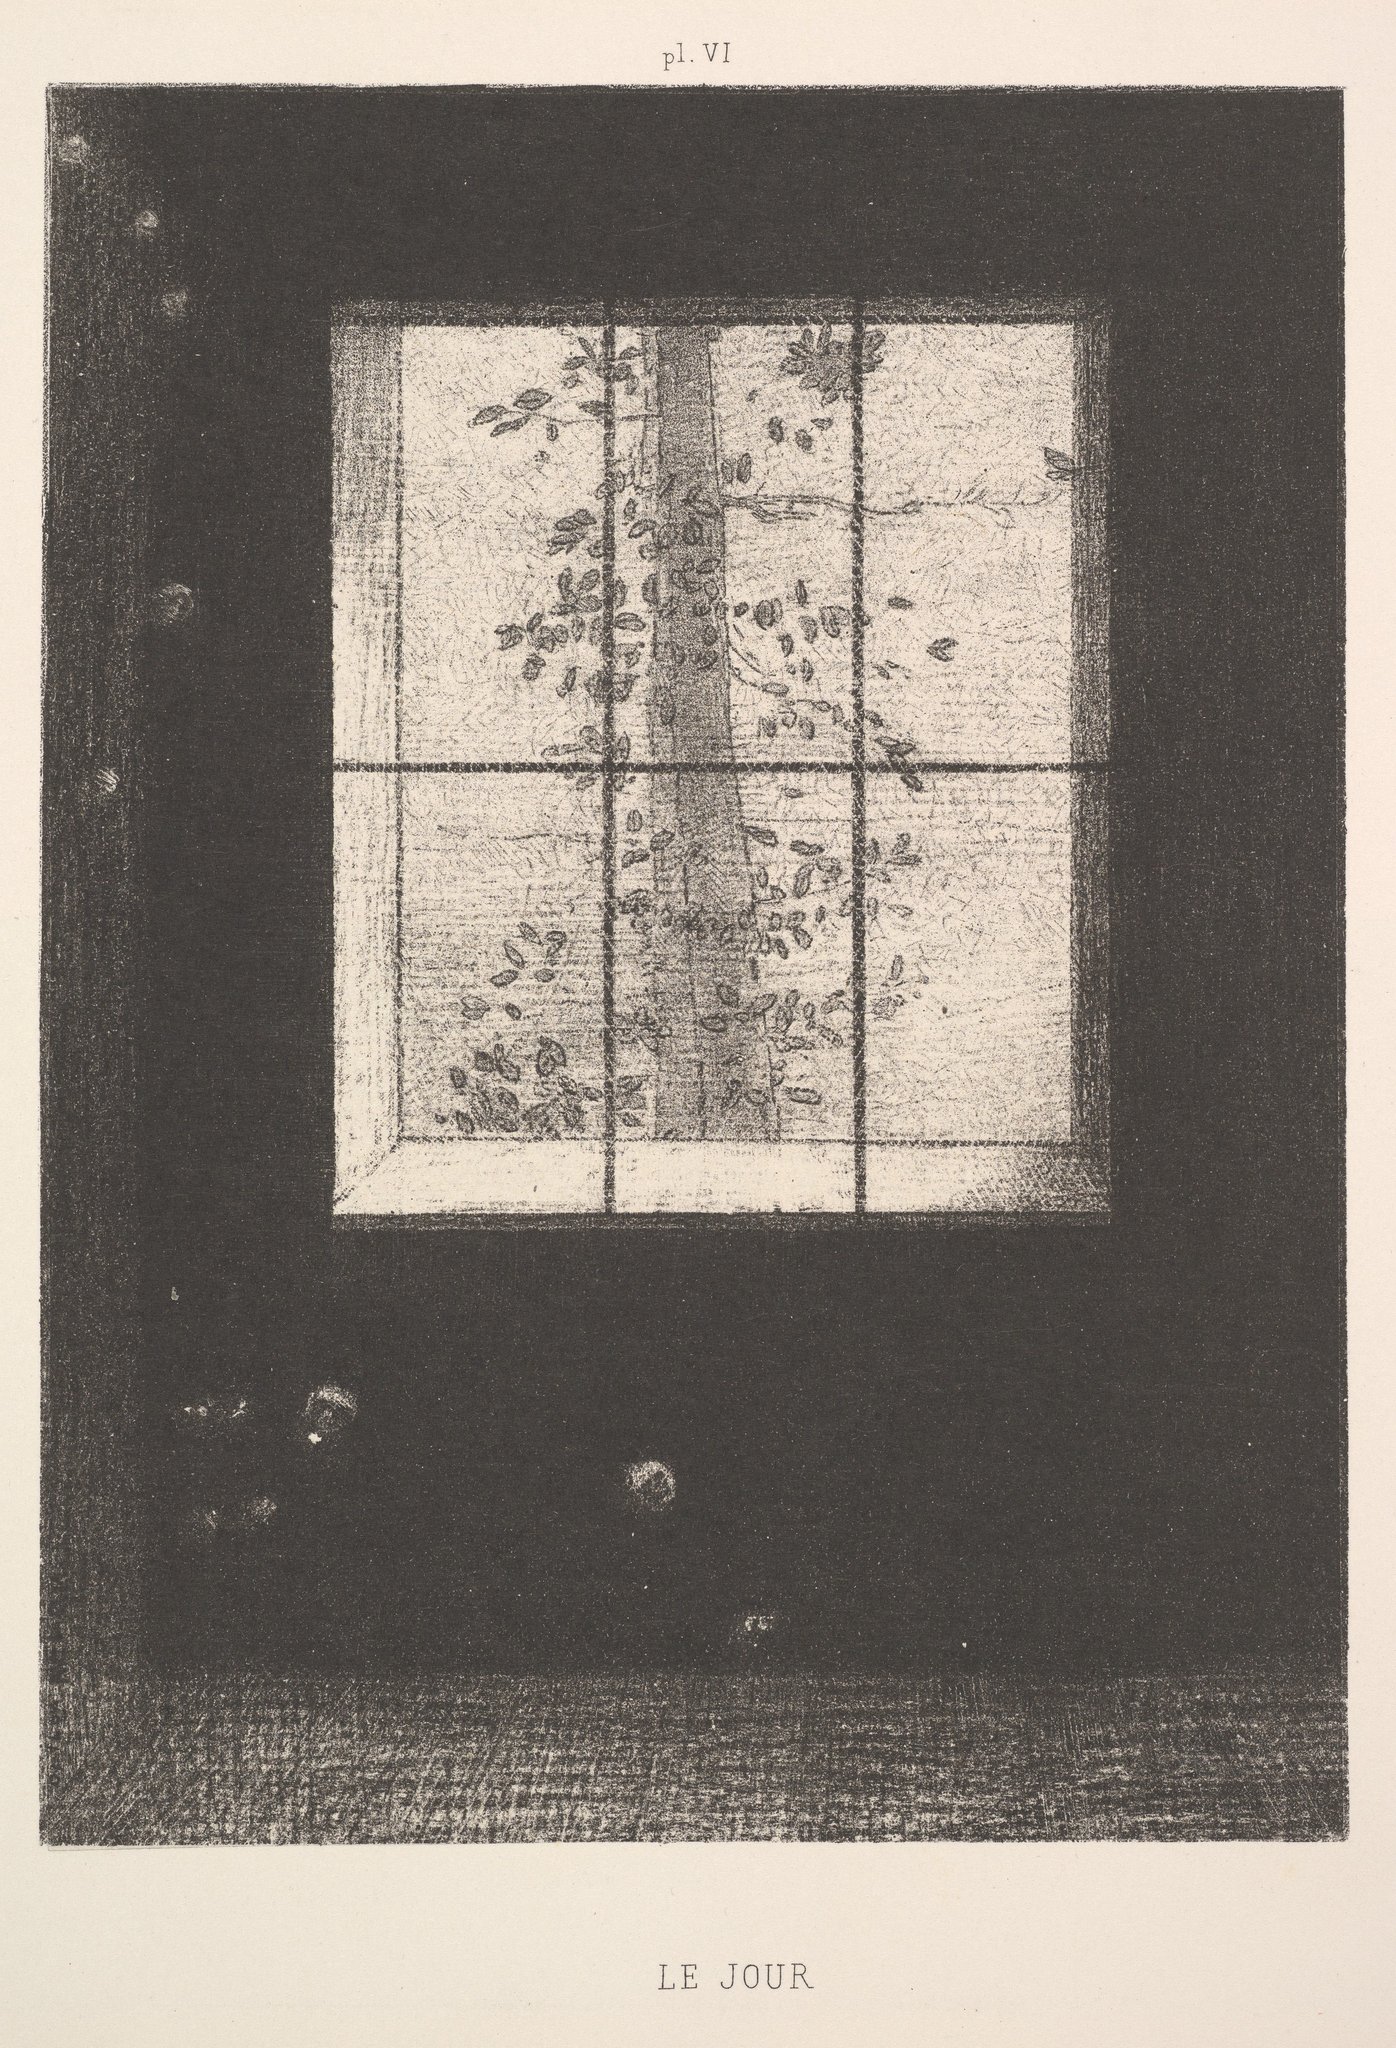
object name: print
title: Day (Le Jour), from the series, Dreams (Songes), plate VI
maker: odilon redon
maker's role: artist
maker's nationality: french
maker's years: 1840-1916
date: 1891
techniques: printmaking, lithograph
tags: windows,trees